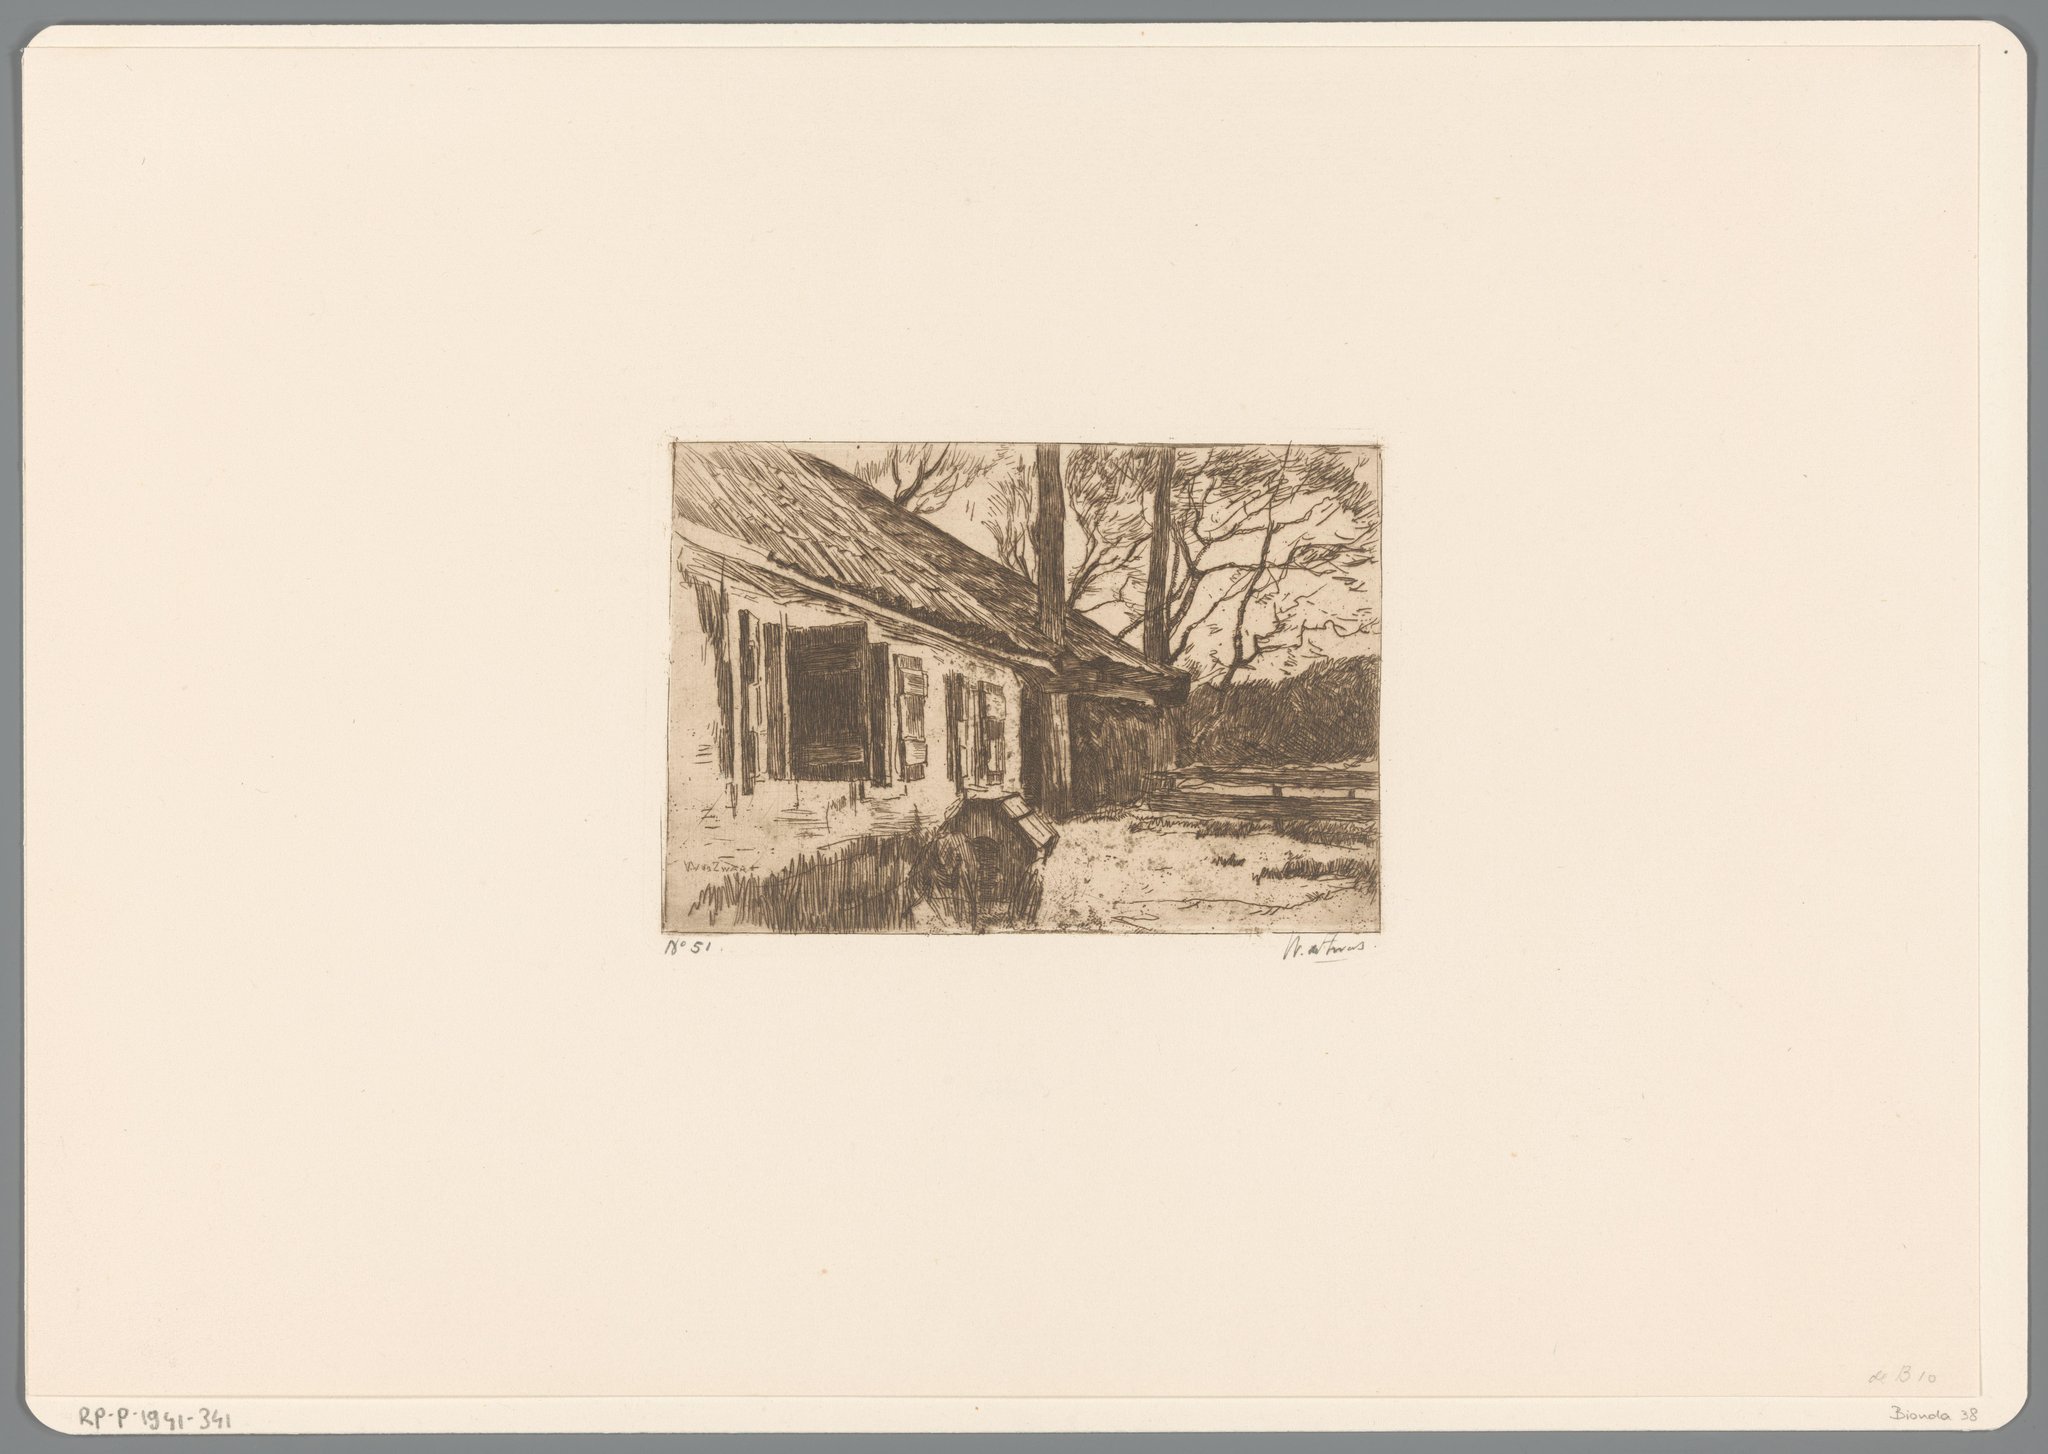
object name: print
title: Boerenwoning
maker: willem de zwart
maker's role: draughtsman, painter, print maker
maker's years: 1862-1931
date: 1889-1890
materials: paper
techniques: drypoint, etching, intaglio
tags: farm or solitary house in landscape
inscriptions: collector's mark: Lugt 2228, collector's mark: Lugt 2760